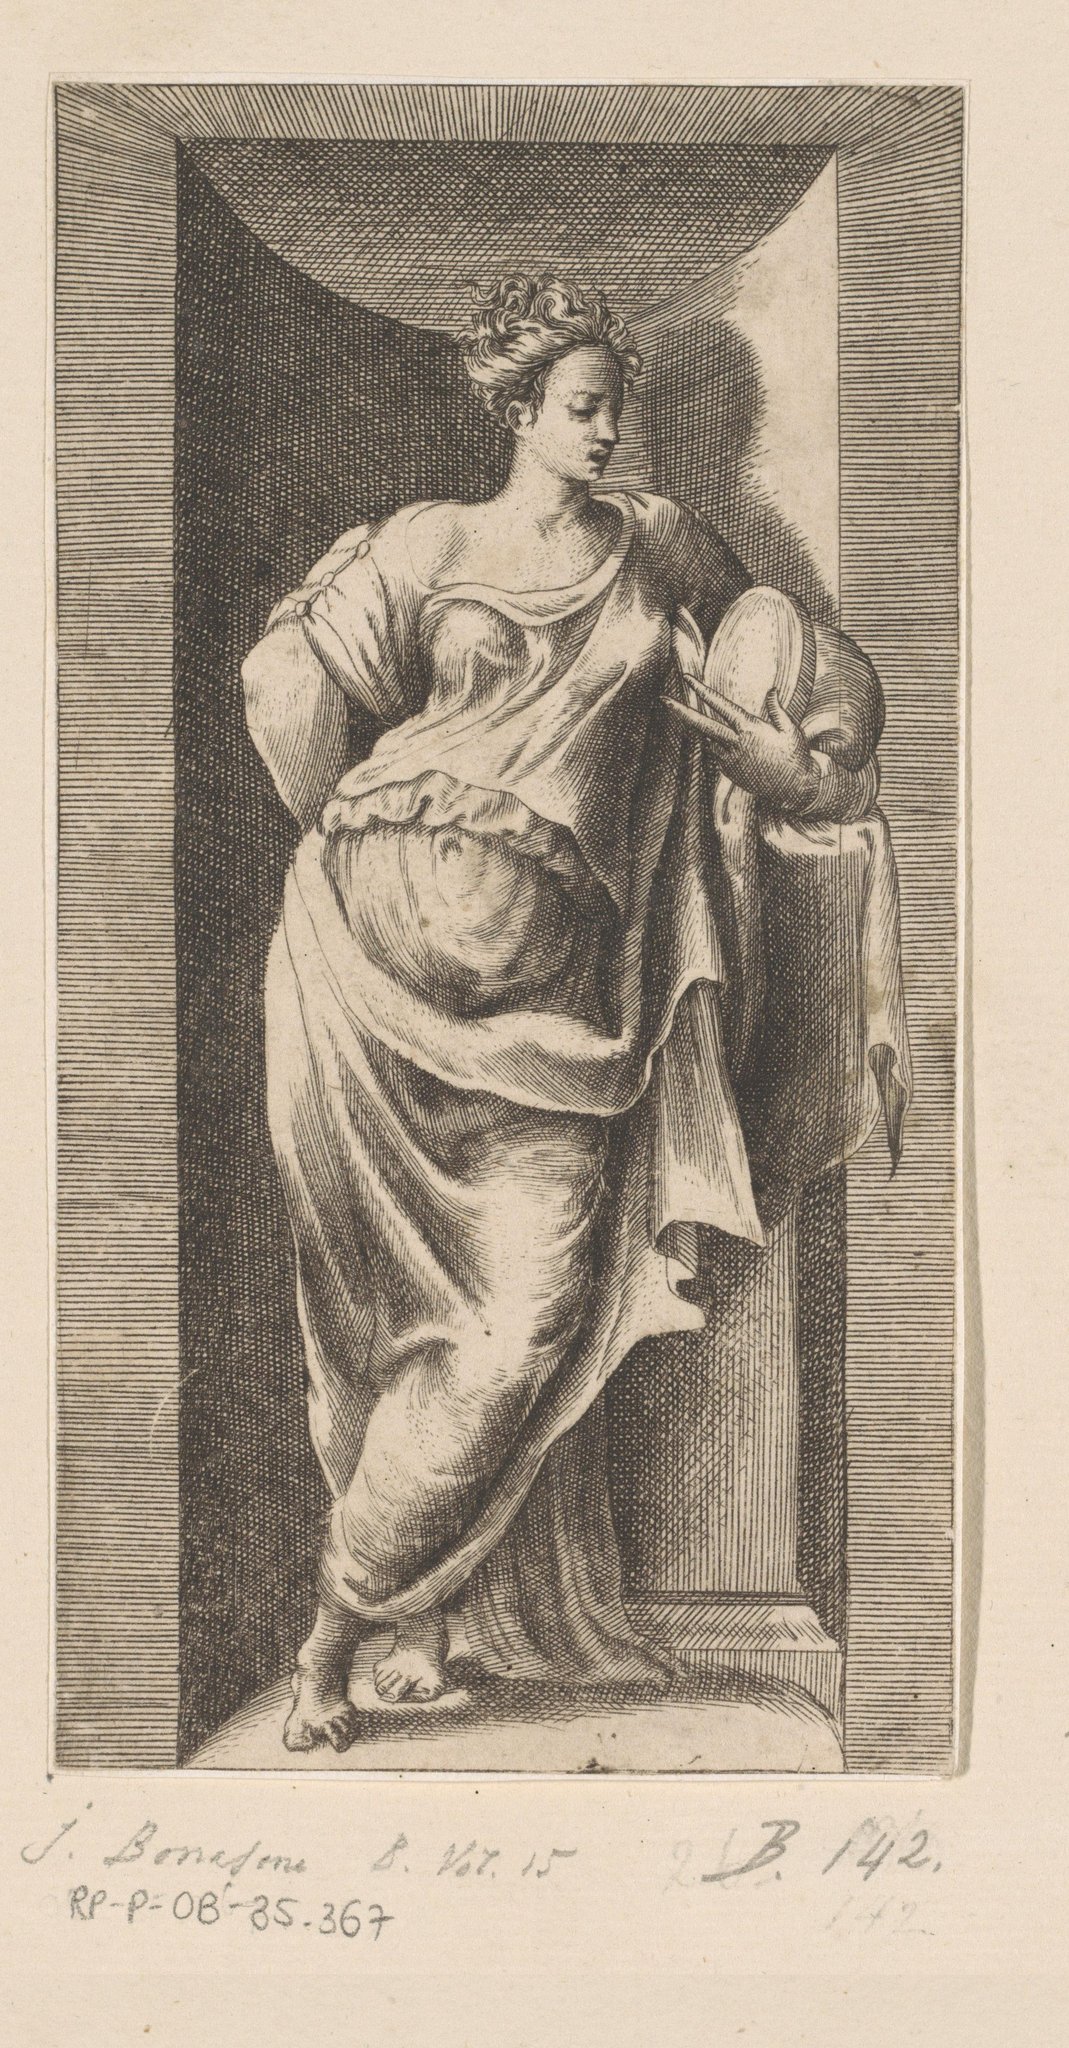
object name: print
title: Muze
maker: giulio bonasone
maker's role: painter, print maker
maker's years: 1510-1576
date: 1501-1580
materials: paper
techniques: engraving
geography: italy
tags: single muses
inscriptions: collector's mark: Lugt 240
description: Prent uit een reeks van vier prenten van beelden van vrouwenfiguren in nissen.